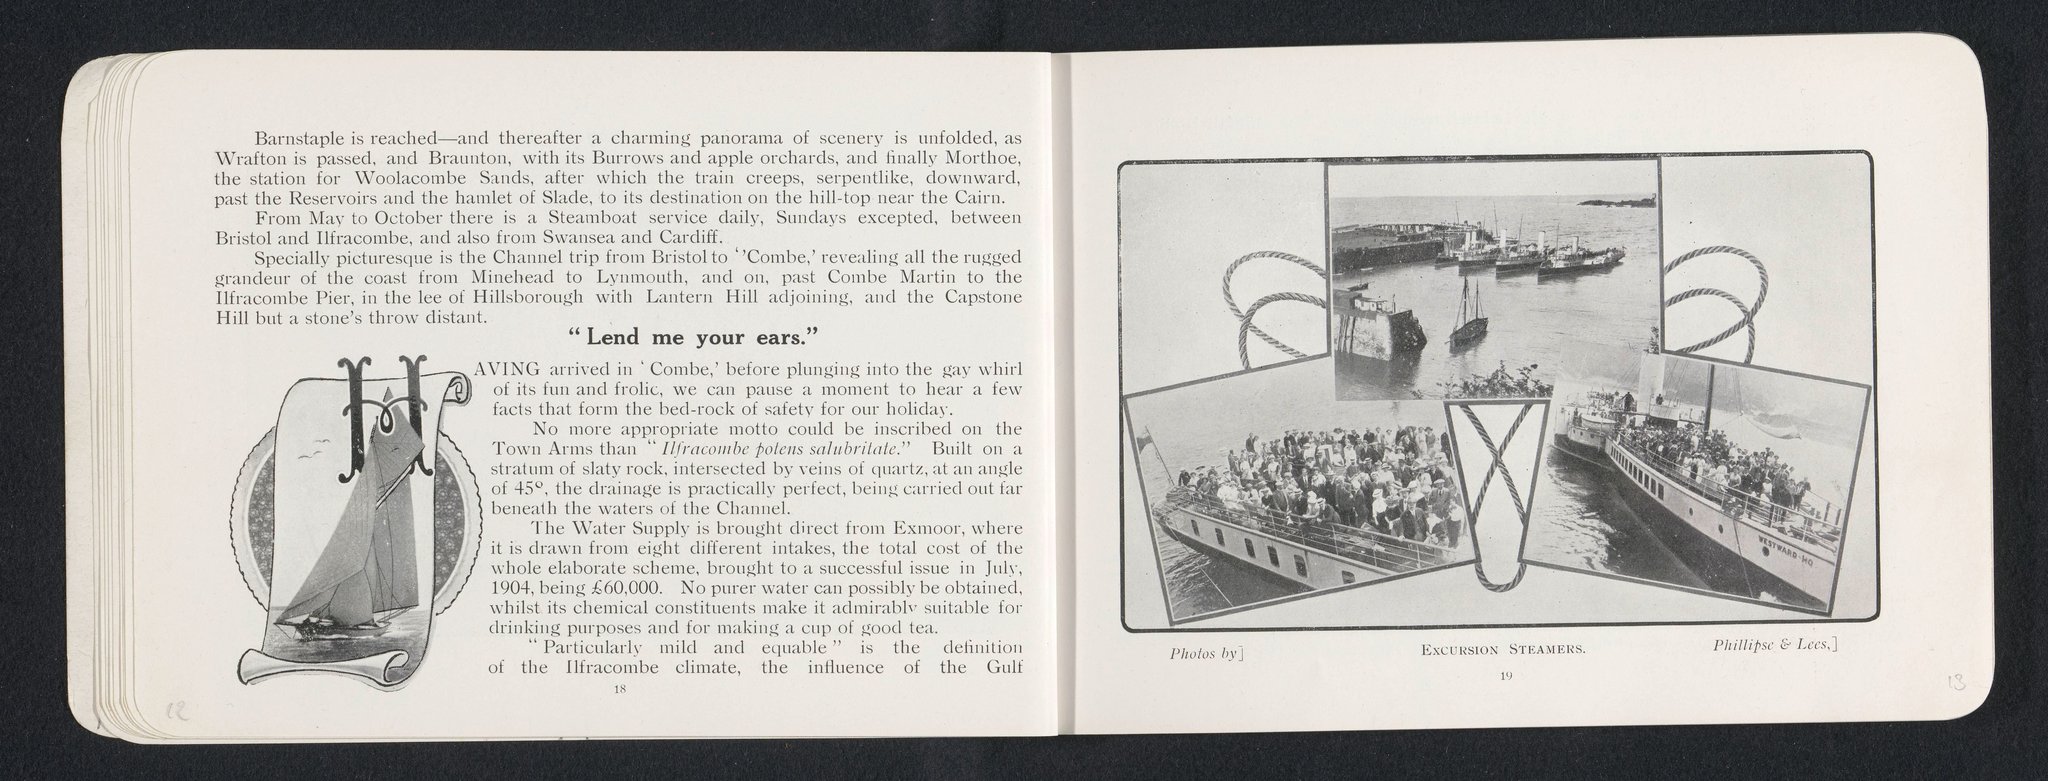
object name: page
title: Zeilschip te Ilfracombe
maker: Anonymous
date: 1900-1920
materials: paper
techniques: autotype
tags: sailing-ship, sailing-boat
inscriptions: inscription: ‘Barnstaple (...) of the Gulf’